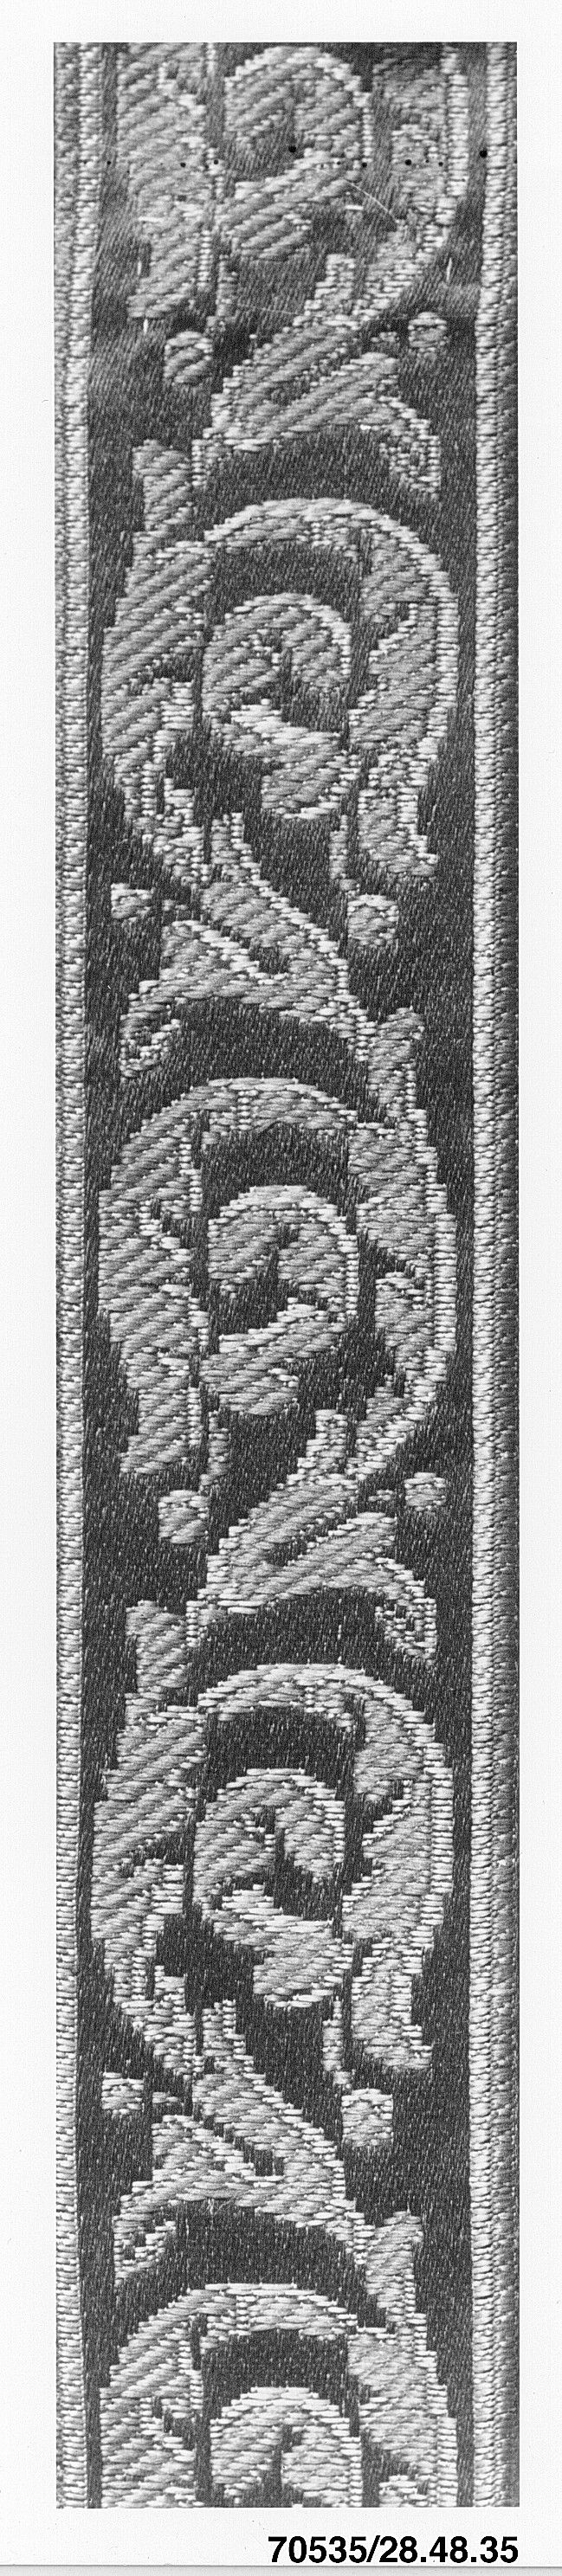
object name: border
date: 1801-1900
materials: silk